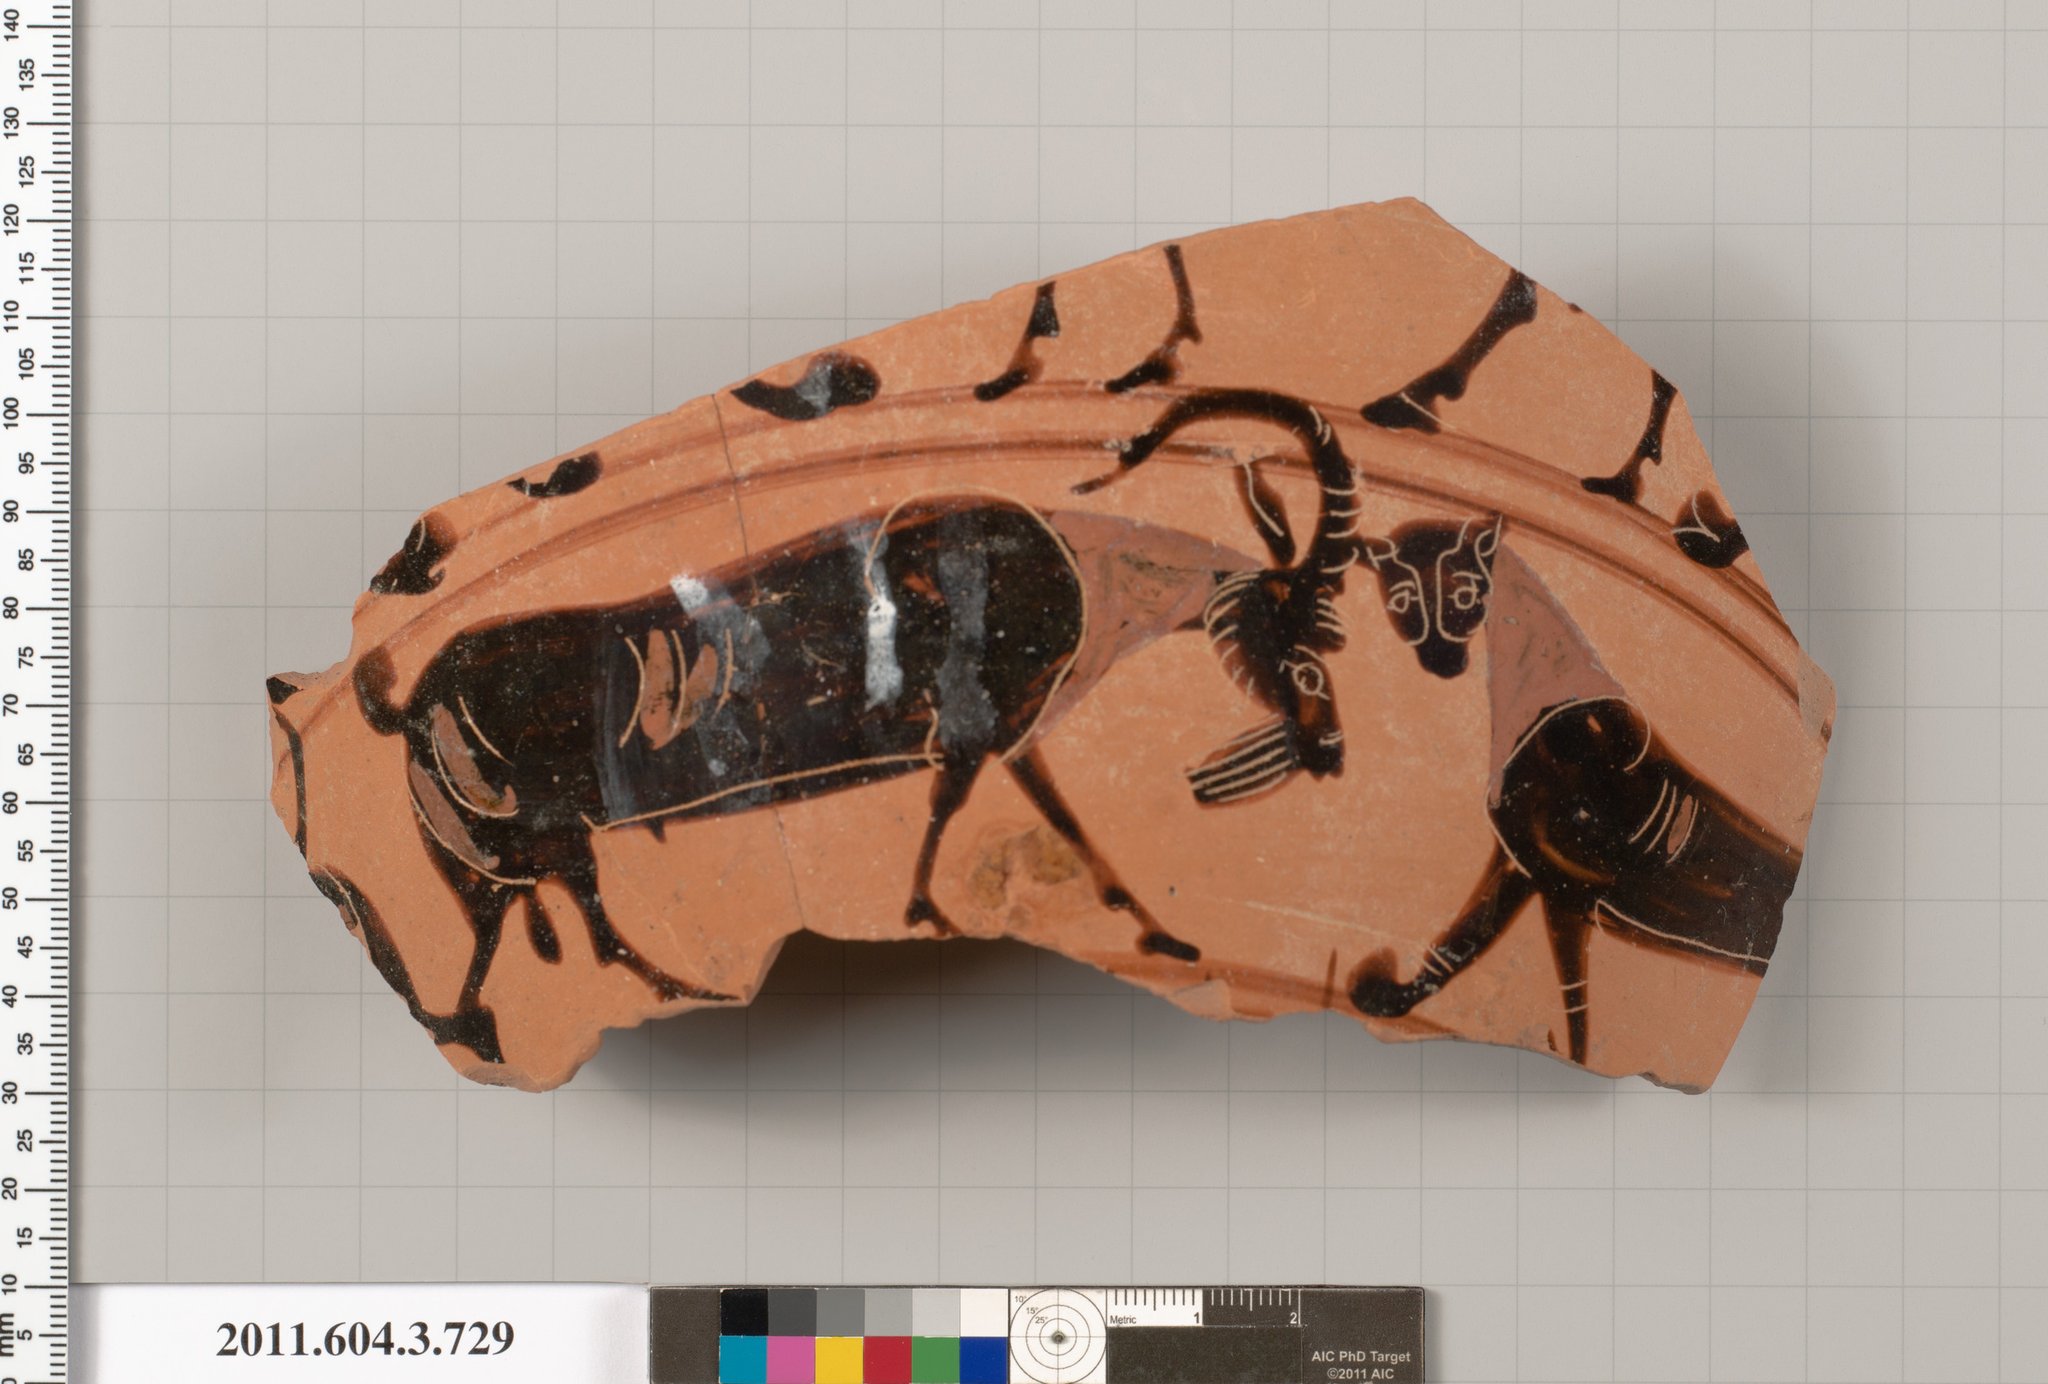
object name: neck amphora, tyrrhenian fragment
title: Terracotta fragment of a neck-amphora (jar)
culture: greek, attic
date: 575-551 BCE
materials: terracotta